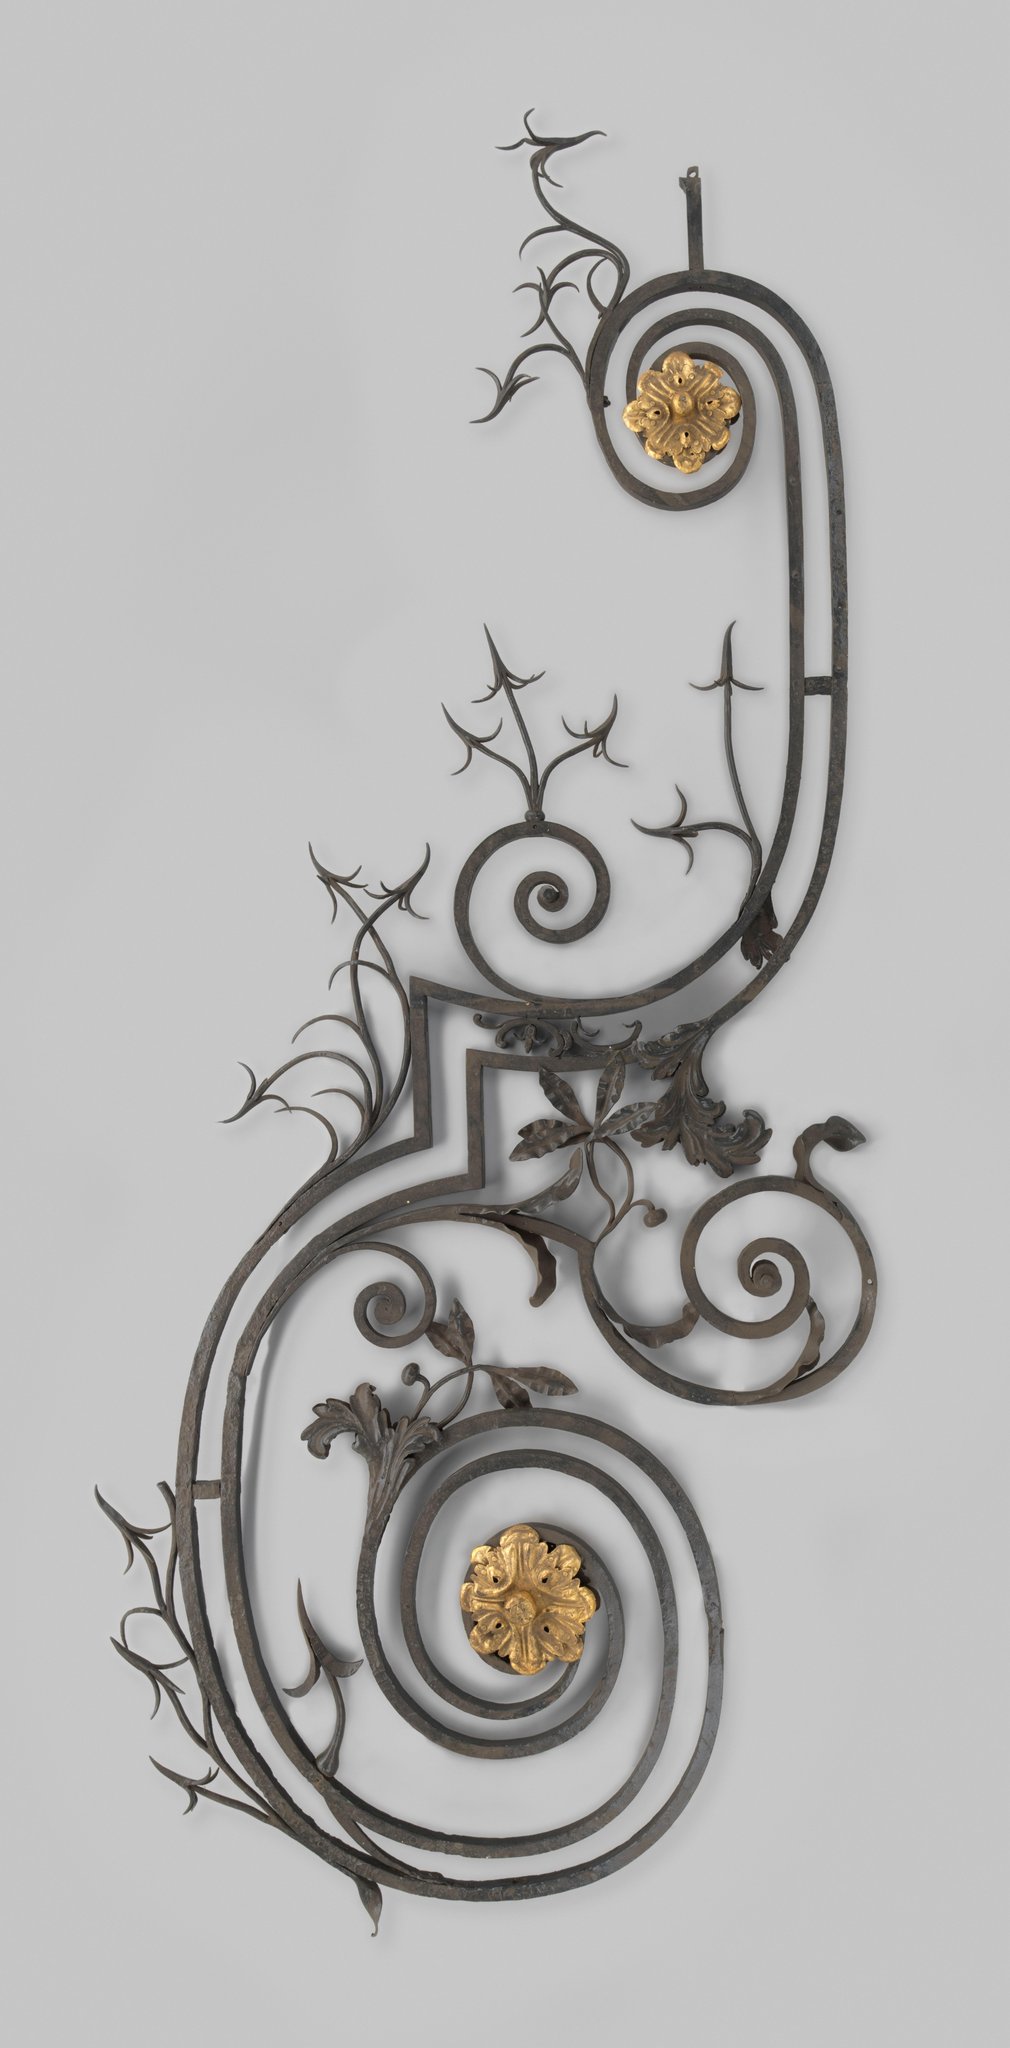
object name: hek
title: Zijelement, hekdeel van het inrijhek Huize de Voorst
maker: daniël marot (i)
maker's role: draughtsman, print maker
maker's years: 1661-1752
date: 1675-1700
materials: iron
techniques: forging, gilding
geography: warnsveld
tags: huis de voorst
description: Smeedijzeren zijelement van het inrijhek van Huize de Voorst.